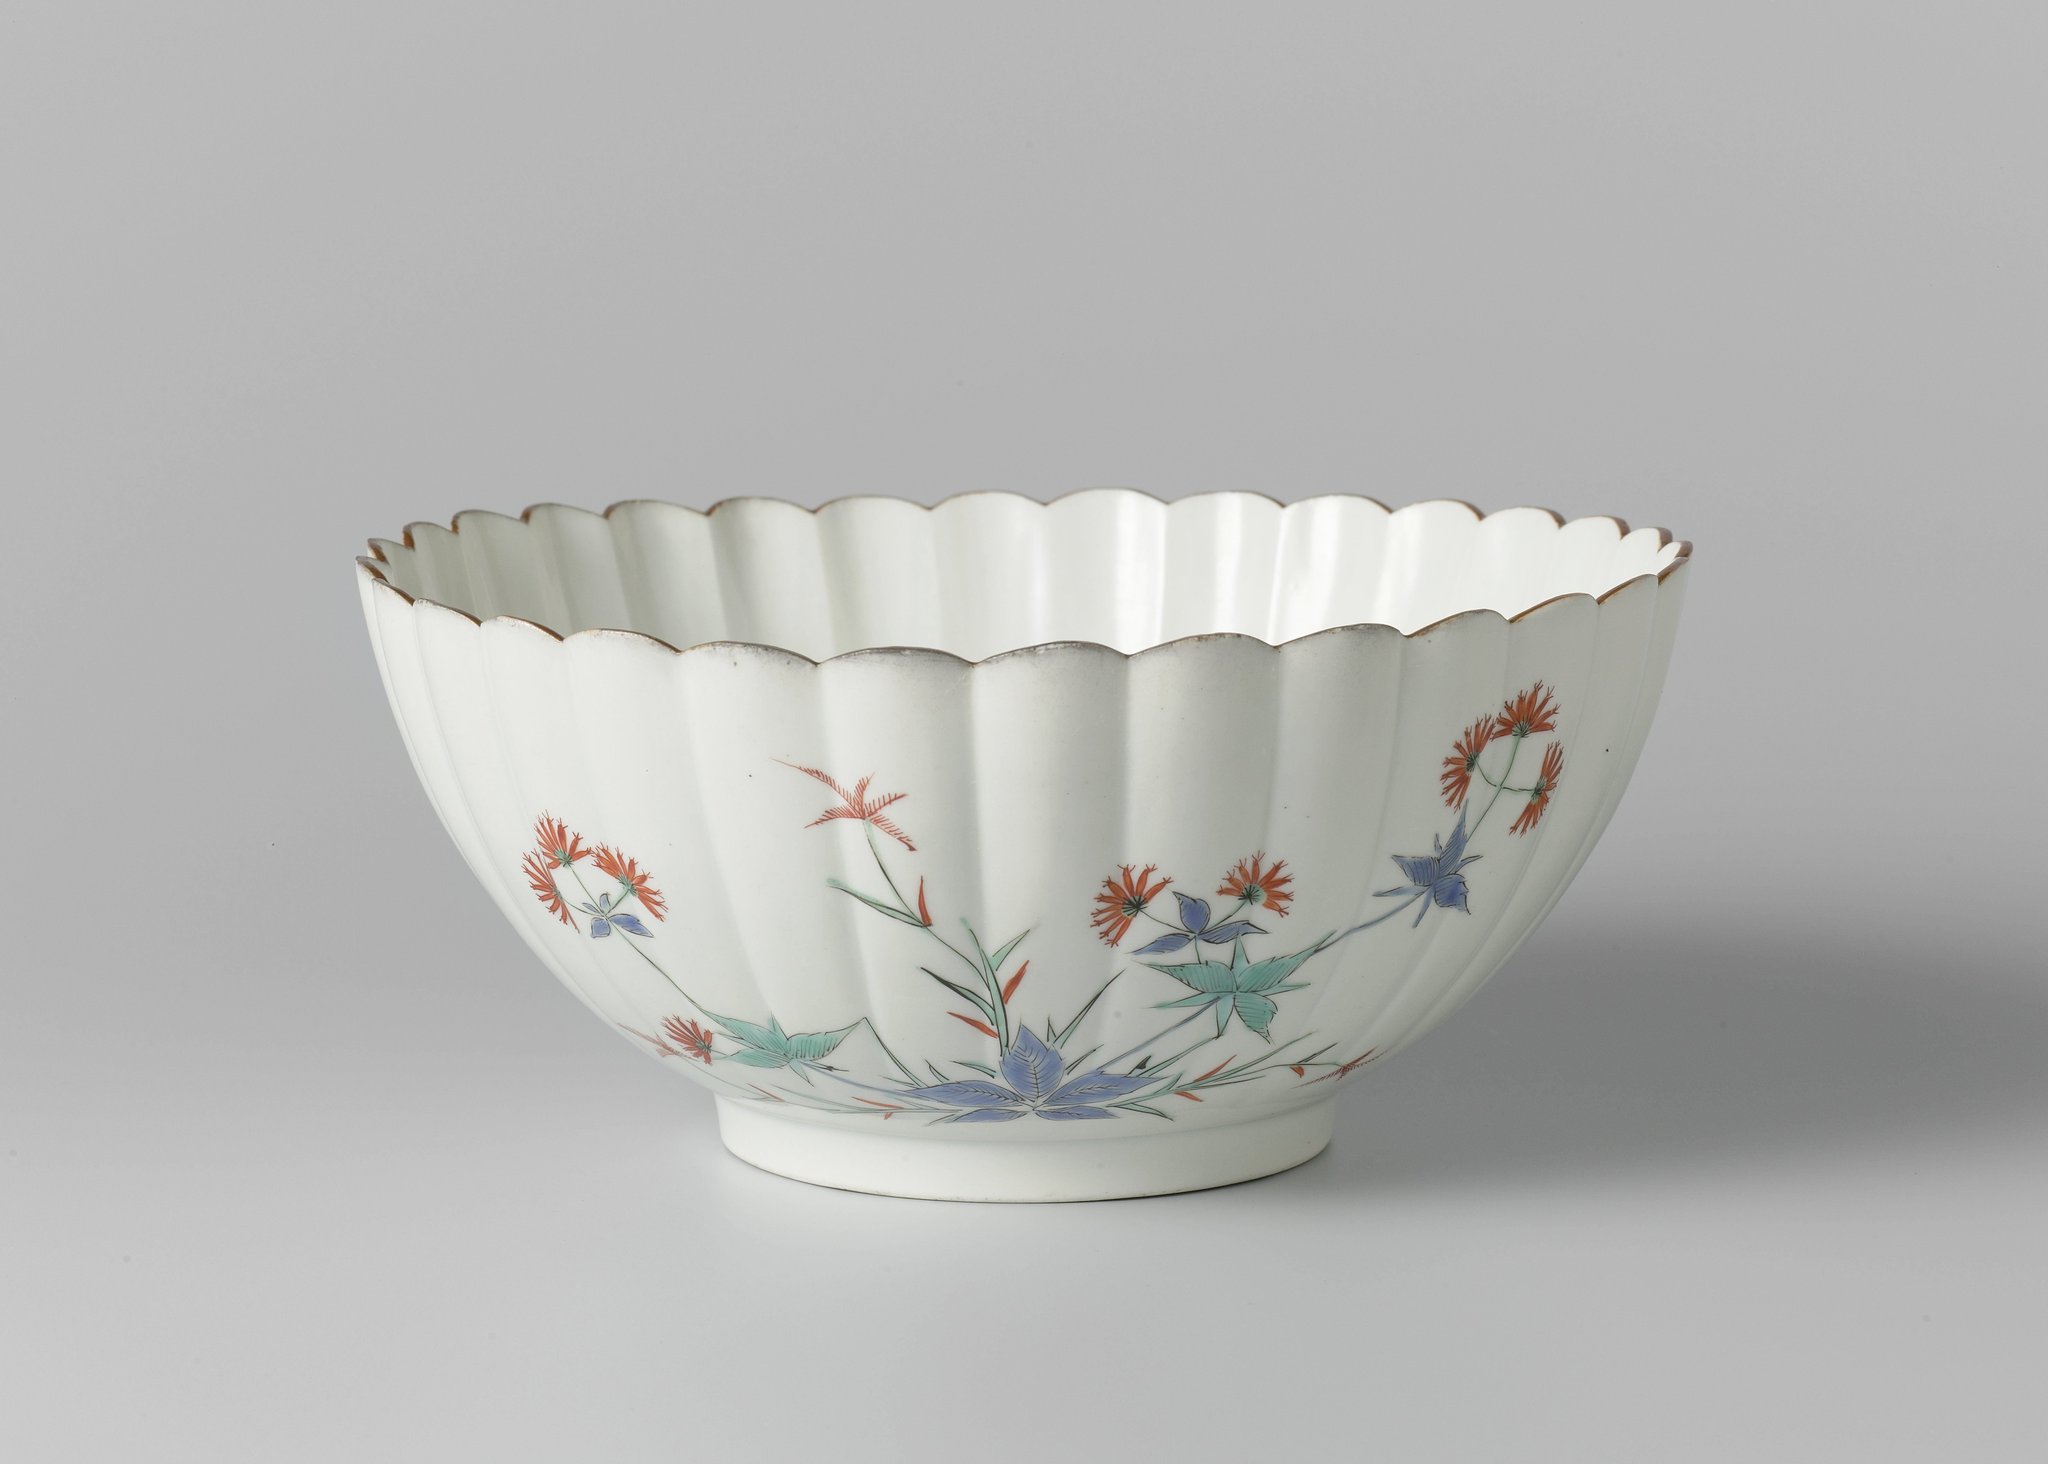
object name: bowl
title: Lobed bowl with patrinia, mistflower and butterflies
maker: Anonymous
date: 1670-1690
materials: glaze, paint, porcelain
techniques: firing, turning, vitrification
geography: arita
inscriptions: label: ‘Collectie Westendorp/ 128’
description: Bowl c. 1680 - 1700